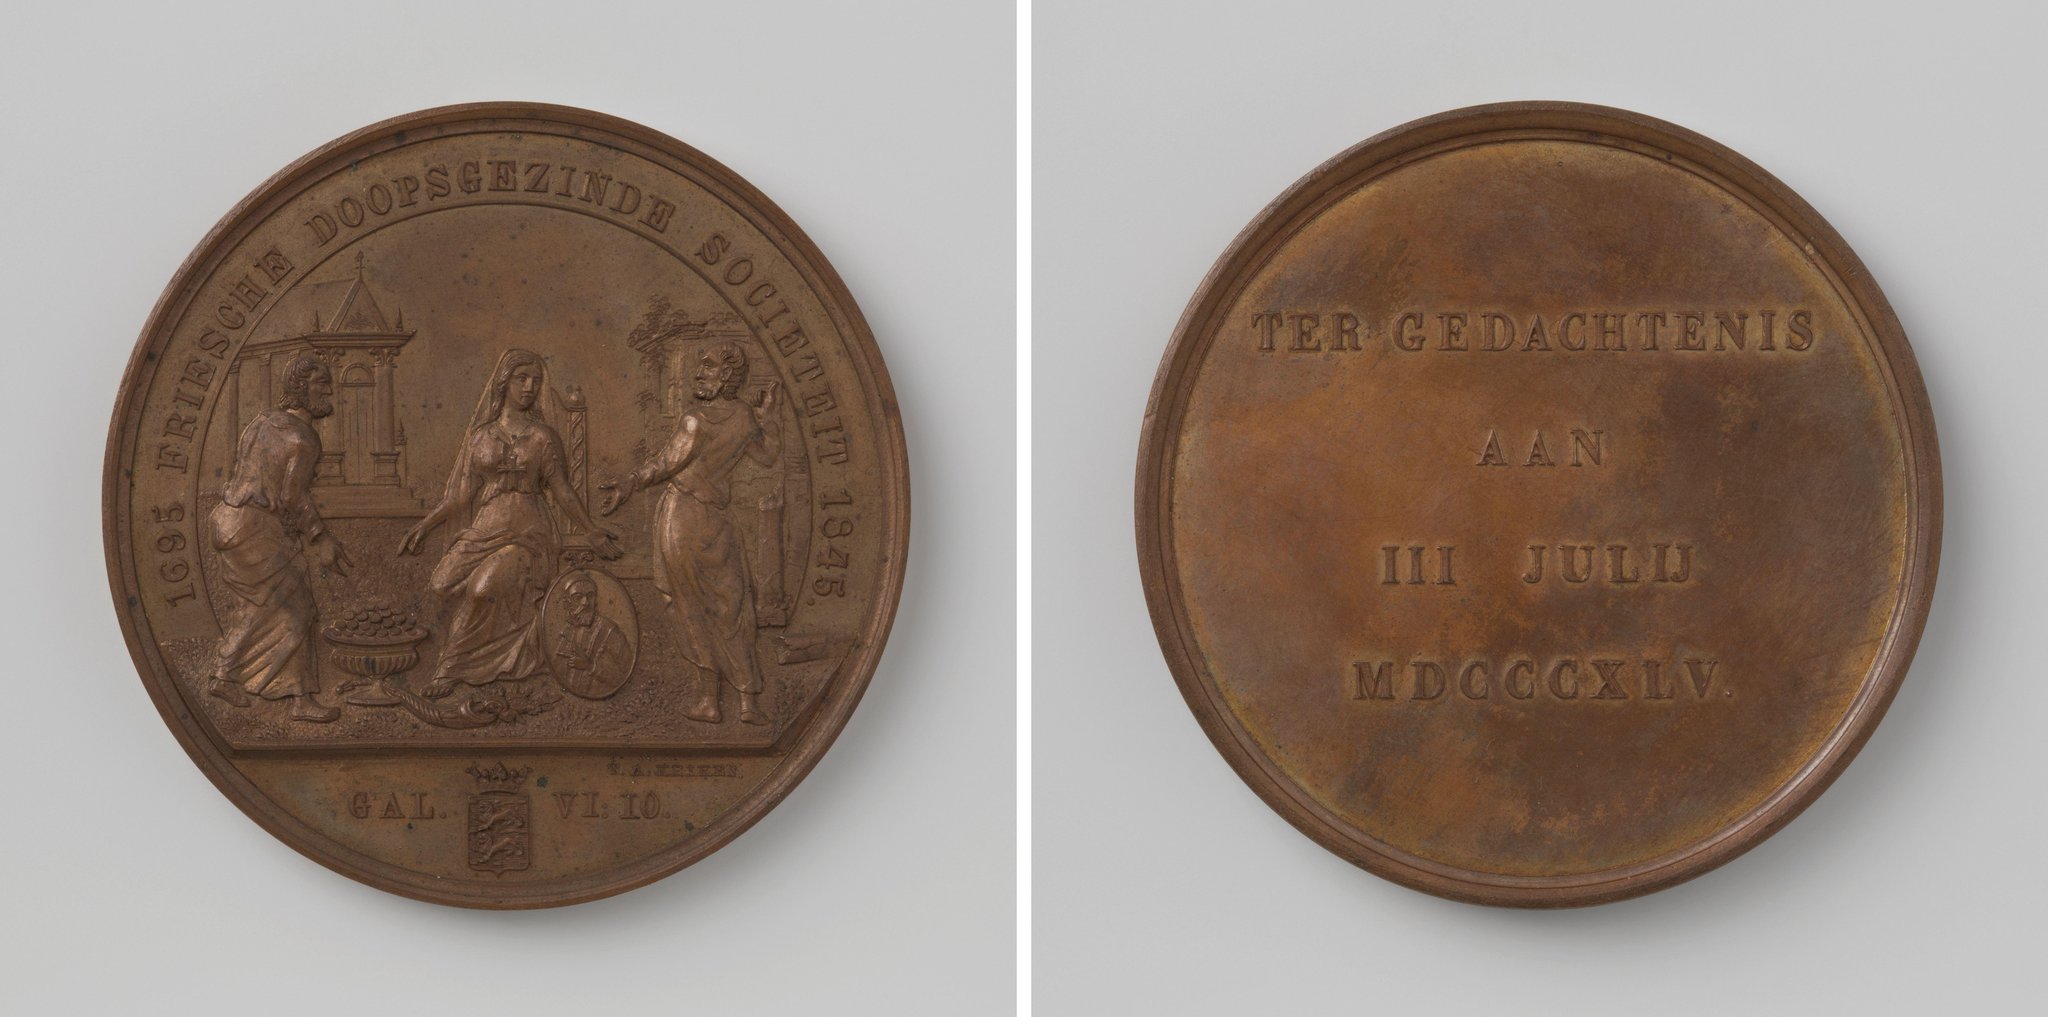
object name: history medal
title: Honderdvijftigjarig bestaan van de Friese Doopsgezinde Societeit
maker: tjeerd keikes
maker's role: medailleur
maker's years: 1804-1886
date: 1845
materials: bronze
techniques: striking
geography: leeuwarden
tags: clergyman